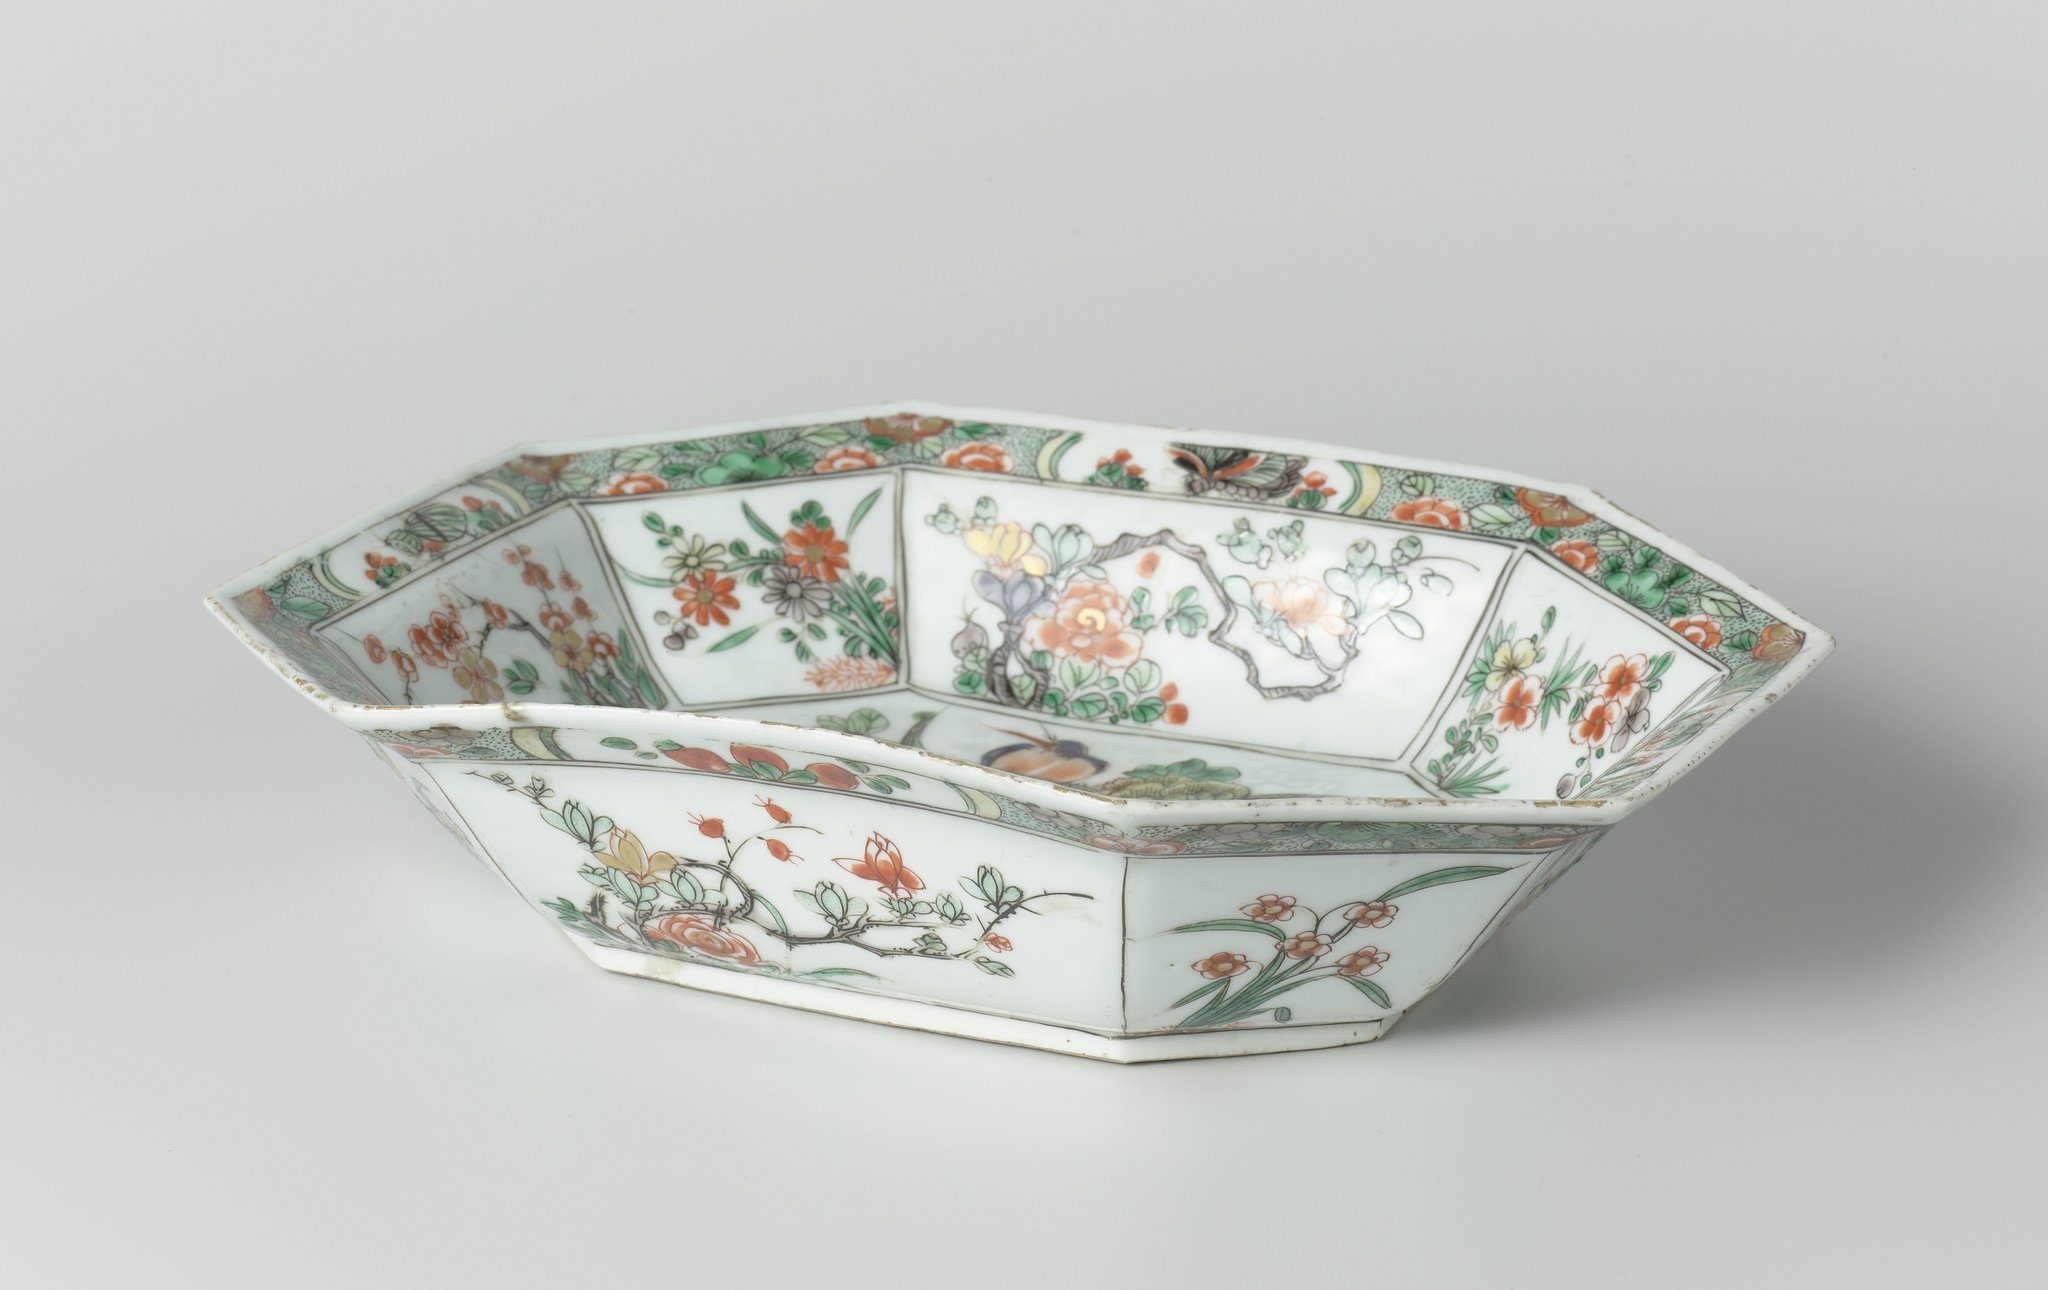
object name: platter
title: Oblong, octagonal dish with flowers, birds and insects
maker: Anonymous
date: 1700-1724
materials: glaze, gold, paint, porcelain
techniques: firing, forming, gilding, vitrification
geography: china